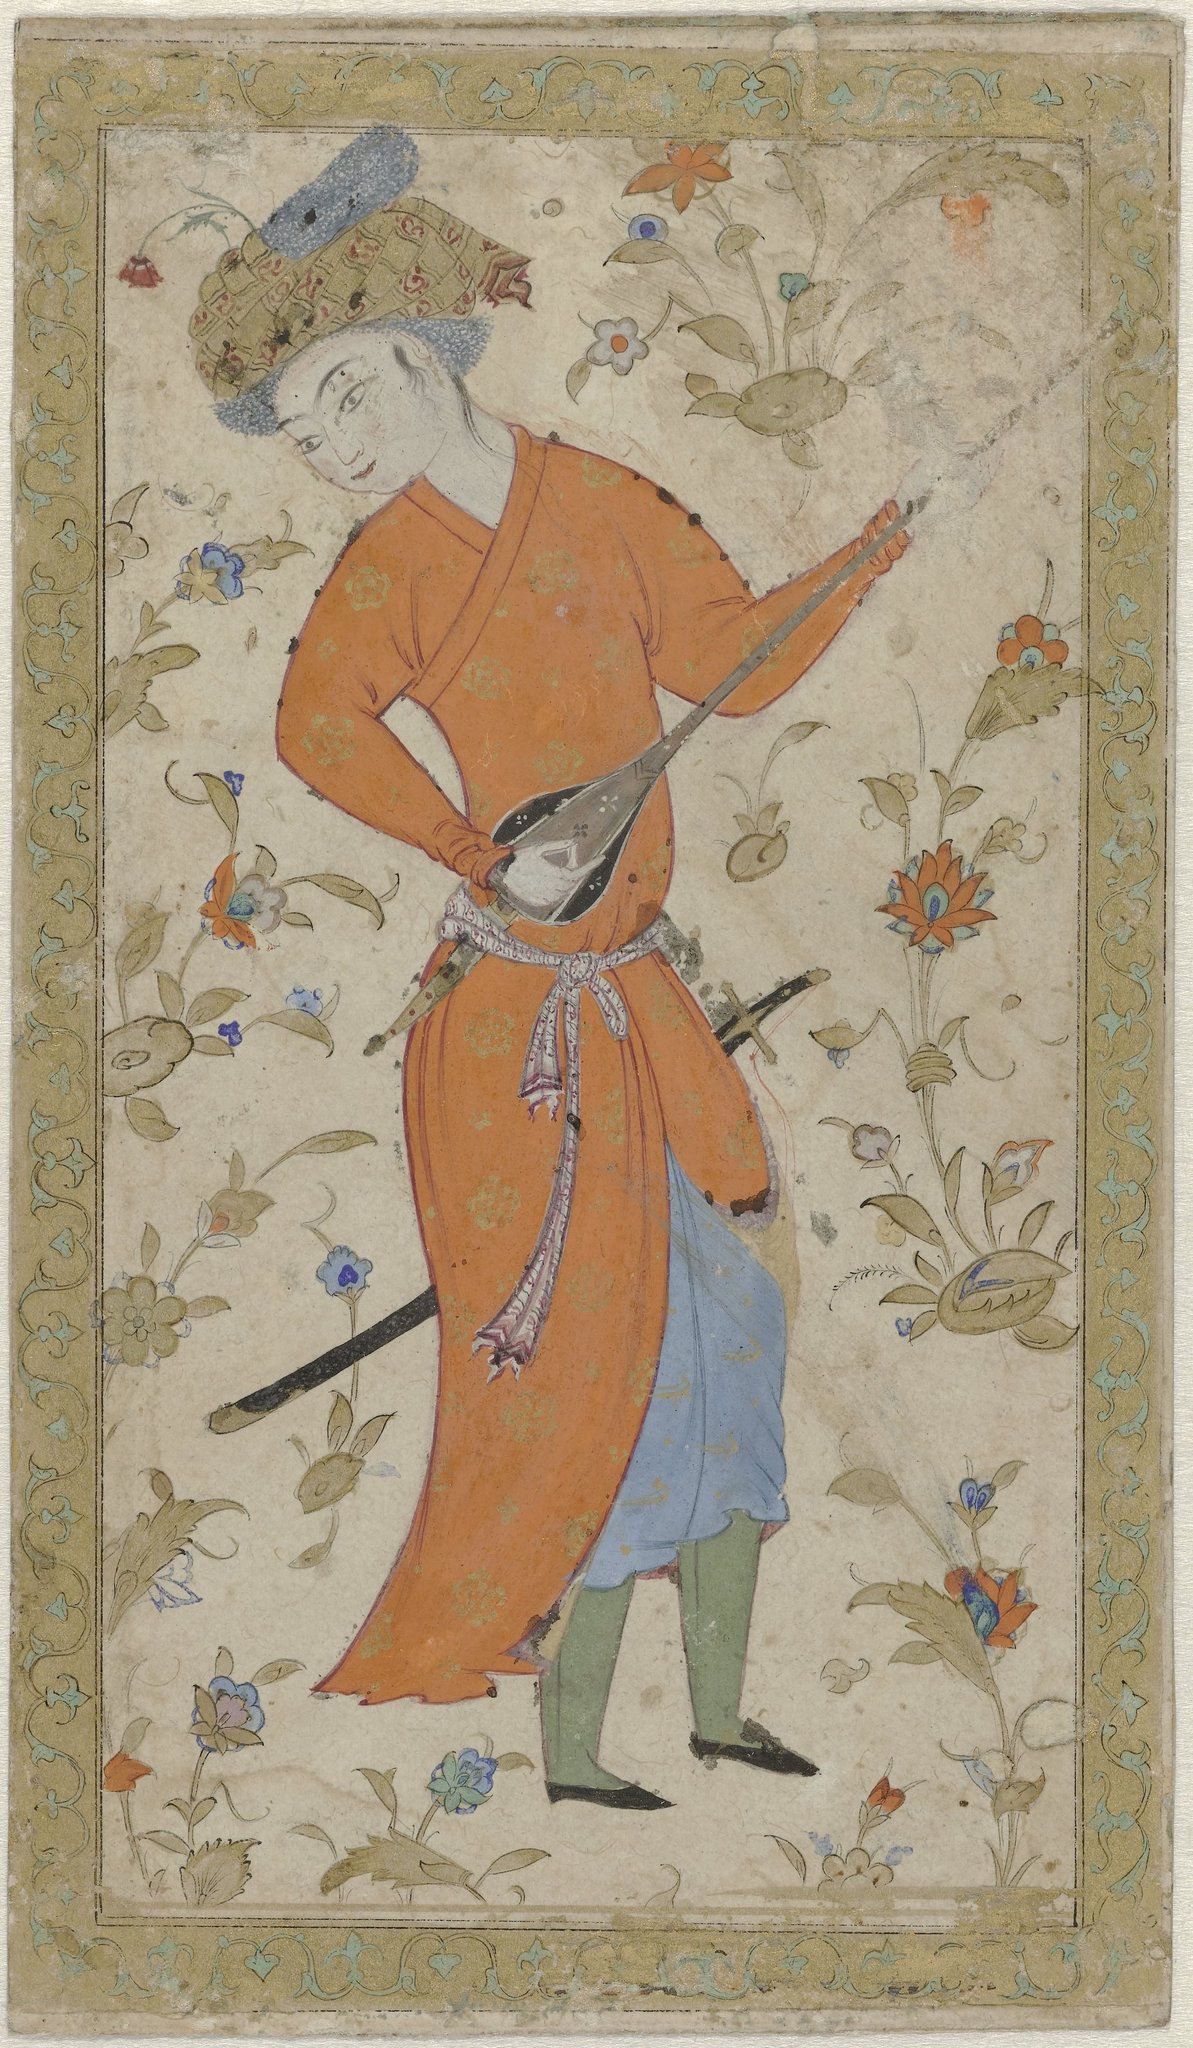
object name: drawing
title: Man in een rood gewaad die een muziekinstrument bespeelt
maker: Anonymous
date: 1570-1590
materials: paper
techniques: brush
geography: iran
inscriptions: inscription: ‘.’